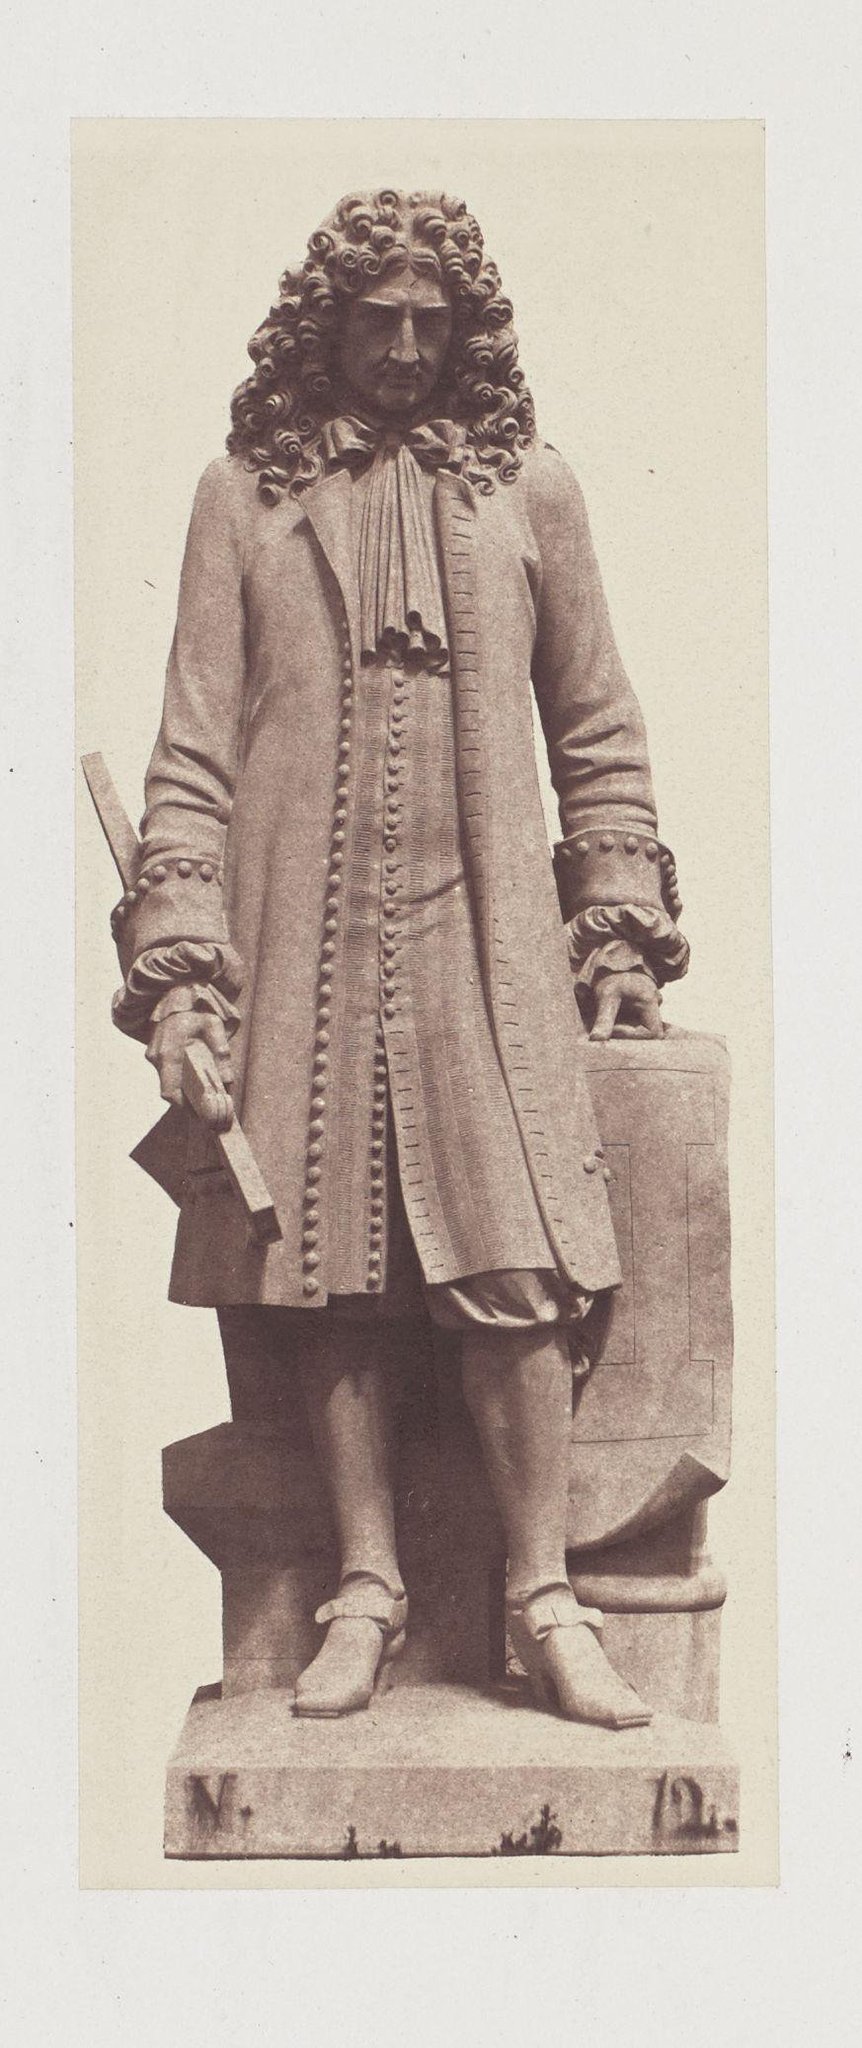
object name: album leaf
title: Gipsmodellen voor beeldhouwwerken op het Palais du Louvre: links "Bruant" door Armand Toussaint en rechts "Delorme" door Jean Pierre Dantan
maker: édouard denis baldus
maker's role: fotograaf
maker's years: 1813-1889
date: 1855-1857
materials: paper, photographic support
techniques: salted paper print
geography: paris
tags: piece of sculpture, reproduction of a piece of sculpture, permanent exhibition, museum, paris, tuileries palace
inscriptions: number: ‘V12 en V30’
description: Onderdeel van Réunion des Tuileries au Louvre 1852-1857, album 2.